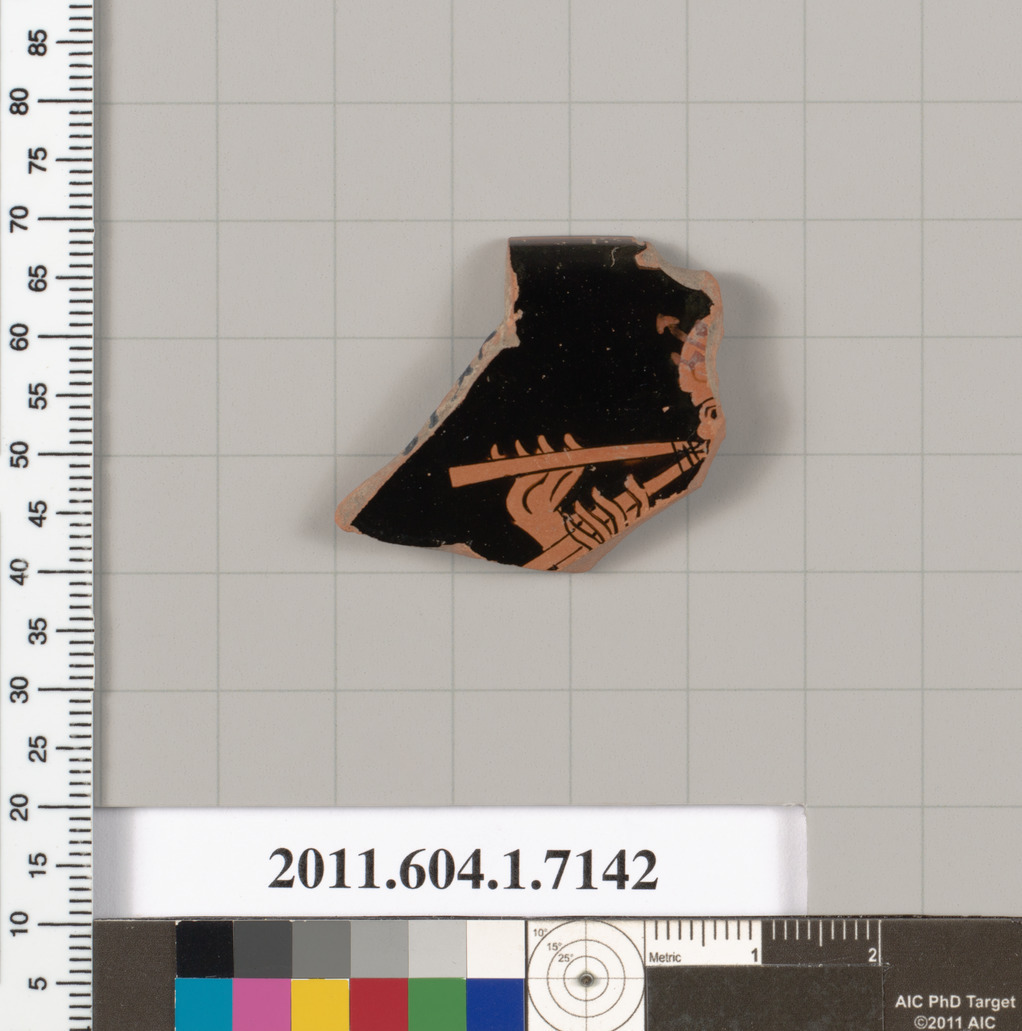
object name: kylix fragment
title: Terracotta rim fragment of a kylix (drinking cup)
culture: greek, attic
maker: makron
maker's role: artist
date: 500-480 BCE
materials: terracotta